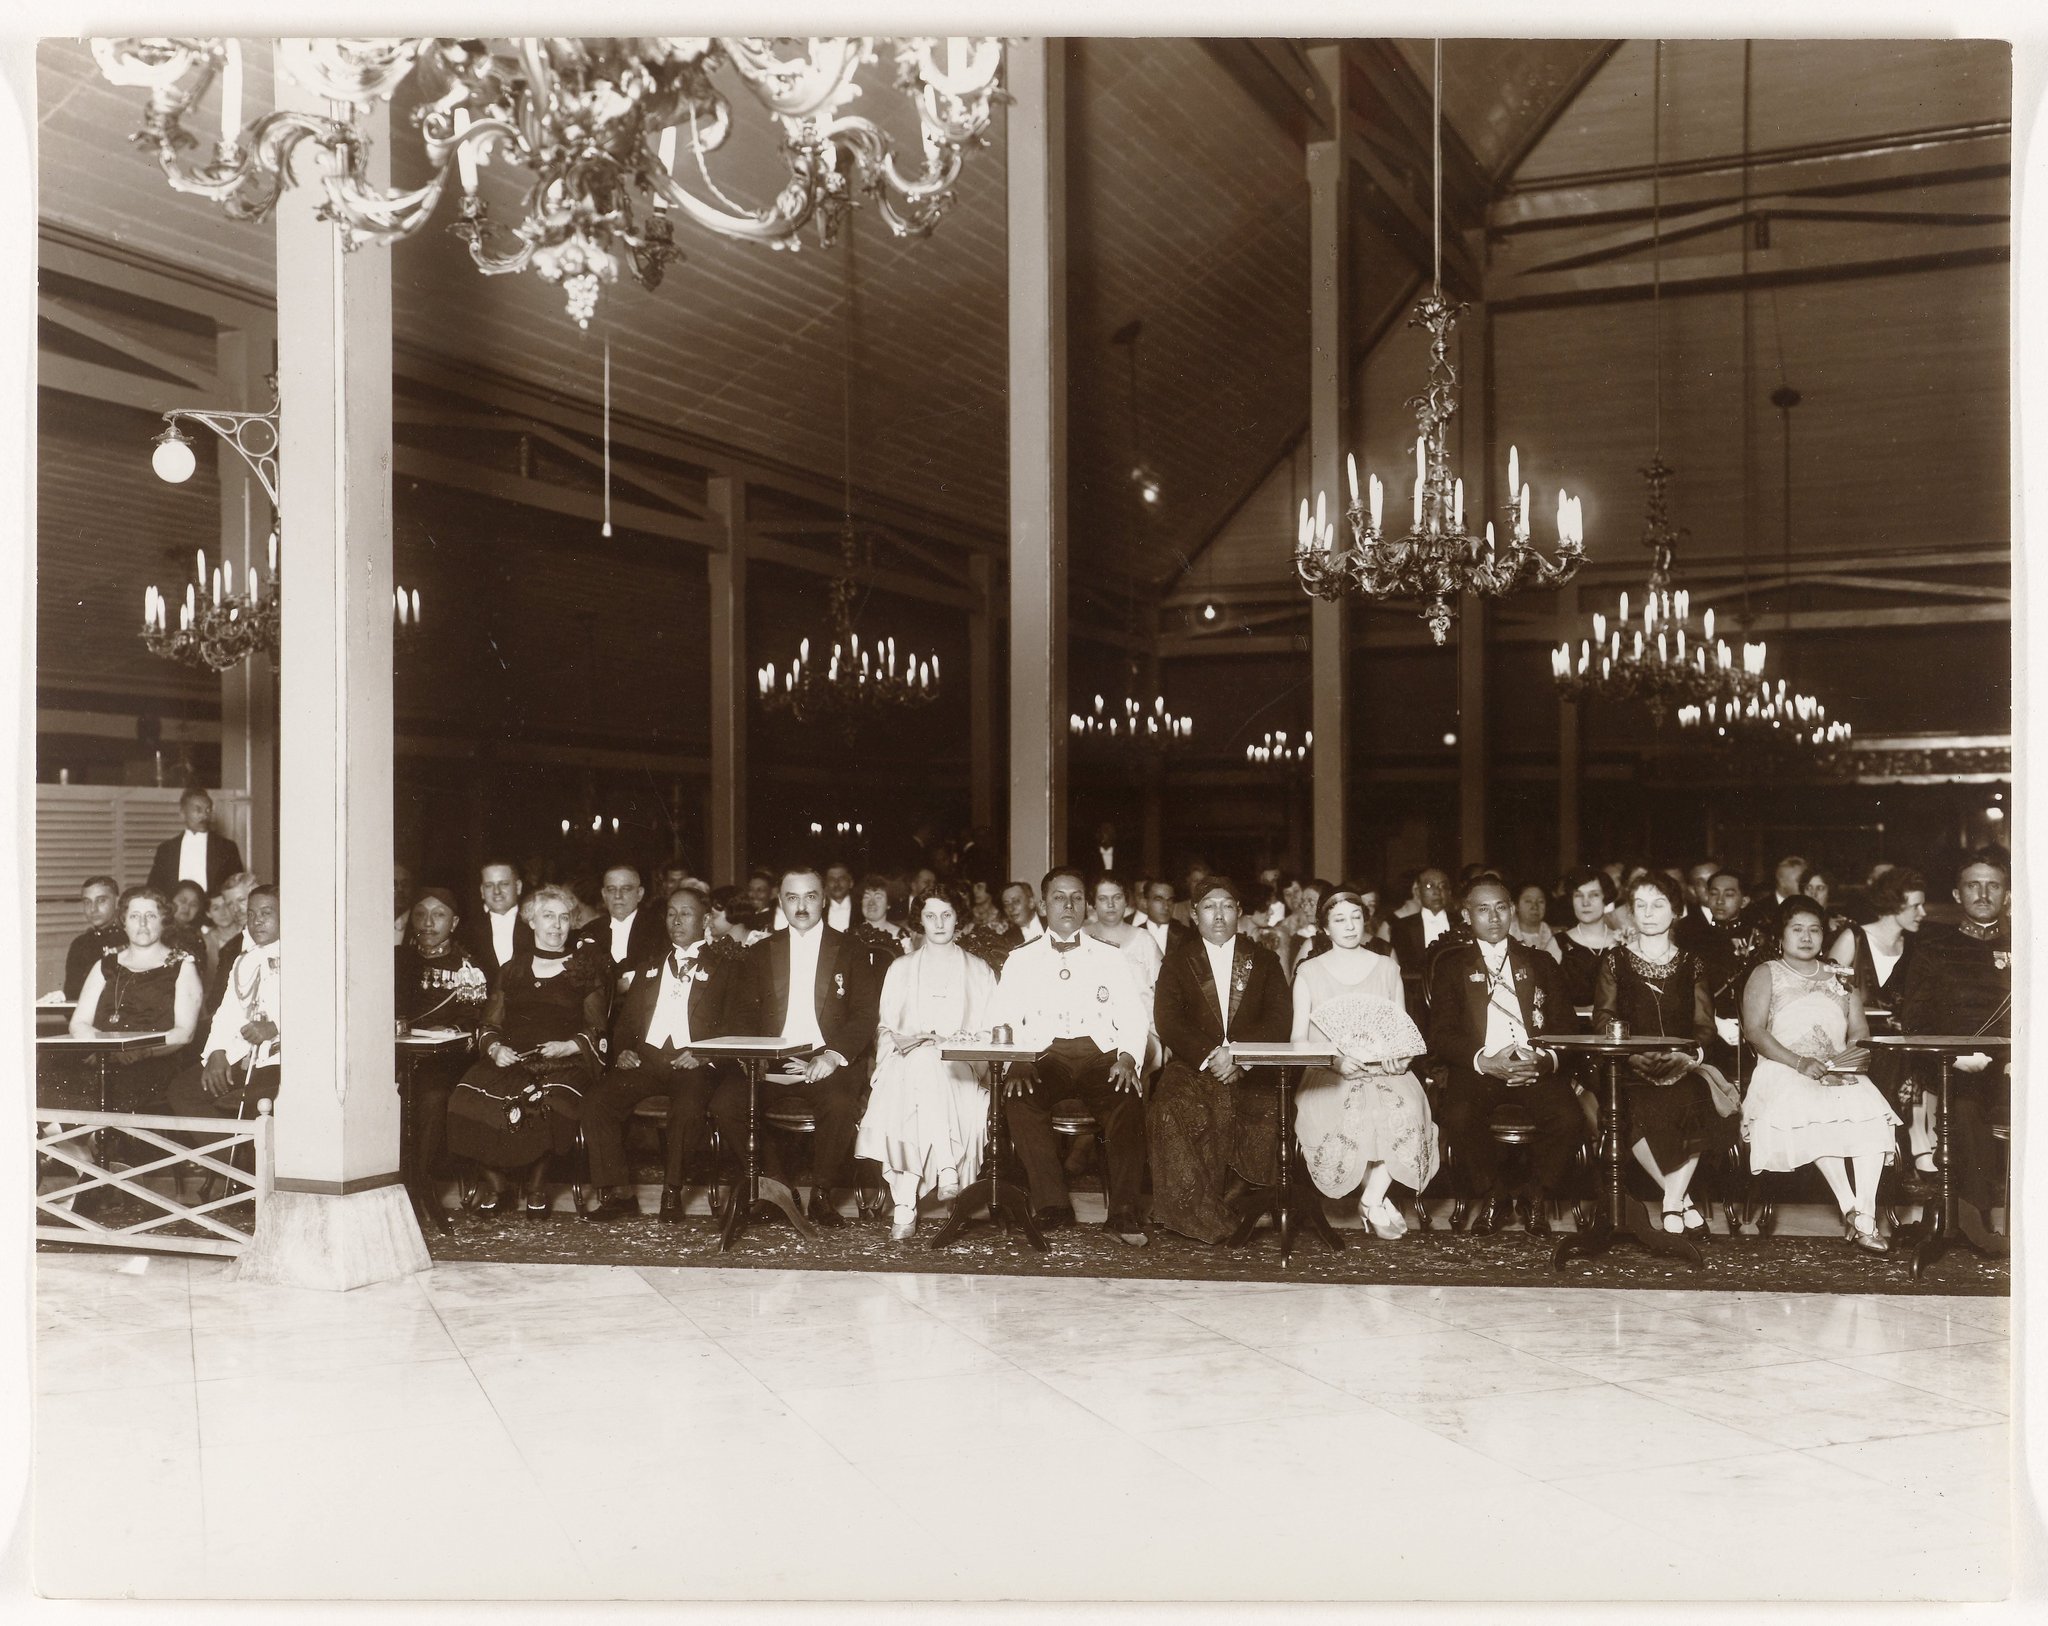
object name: photograph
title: Souper te Solo met de koning en de koningin van Siam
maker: Anonymous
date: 1929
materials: photographic support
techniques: photography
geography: solo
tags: england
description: Souper te Solo met de koning en de koningin van Siam.